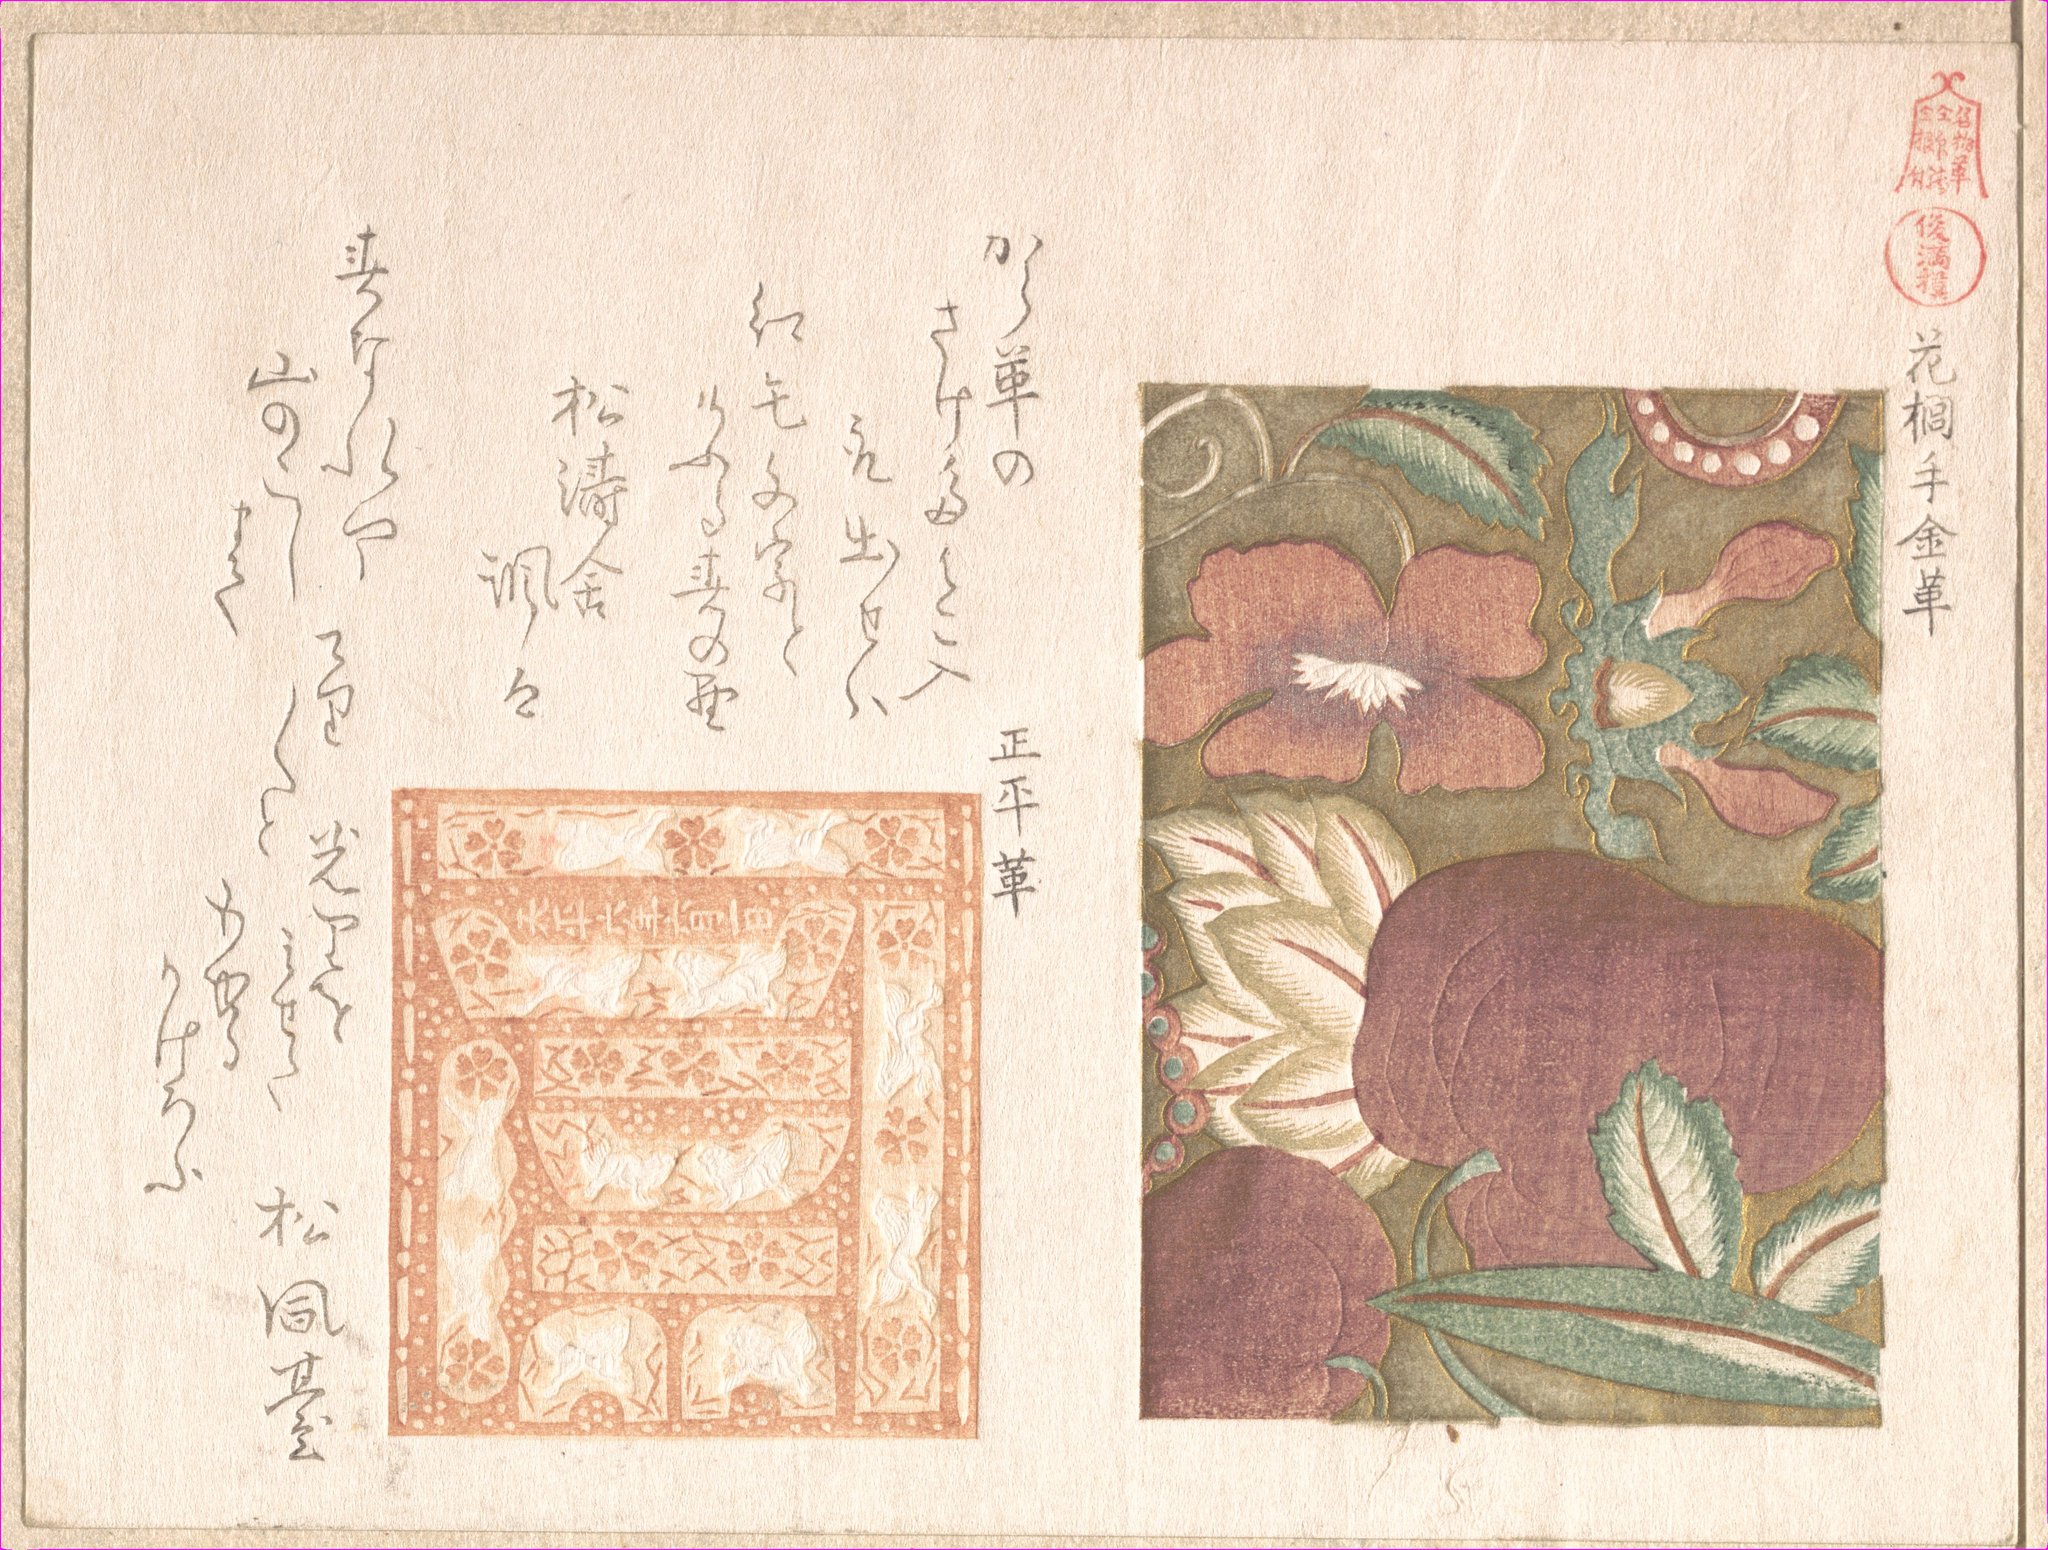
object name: print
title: Designs for Leather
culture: japanese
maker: kubo shunman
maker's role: artist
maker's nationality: japanese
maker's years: 1757-1820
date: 1801-1900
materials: ink, paper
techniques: surimono, woodblock print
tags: flowers,leaves